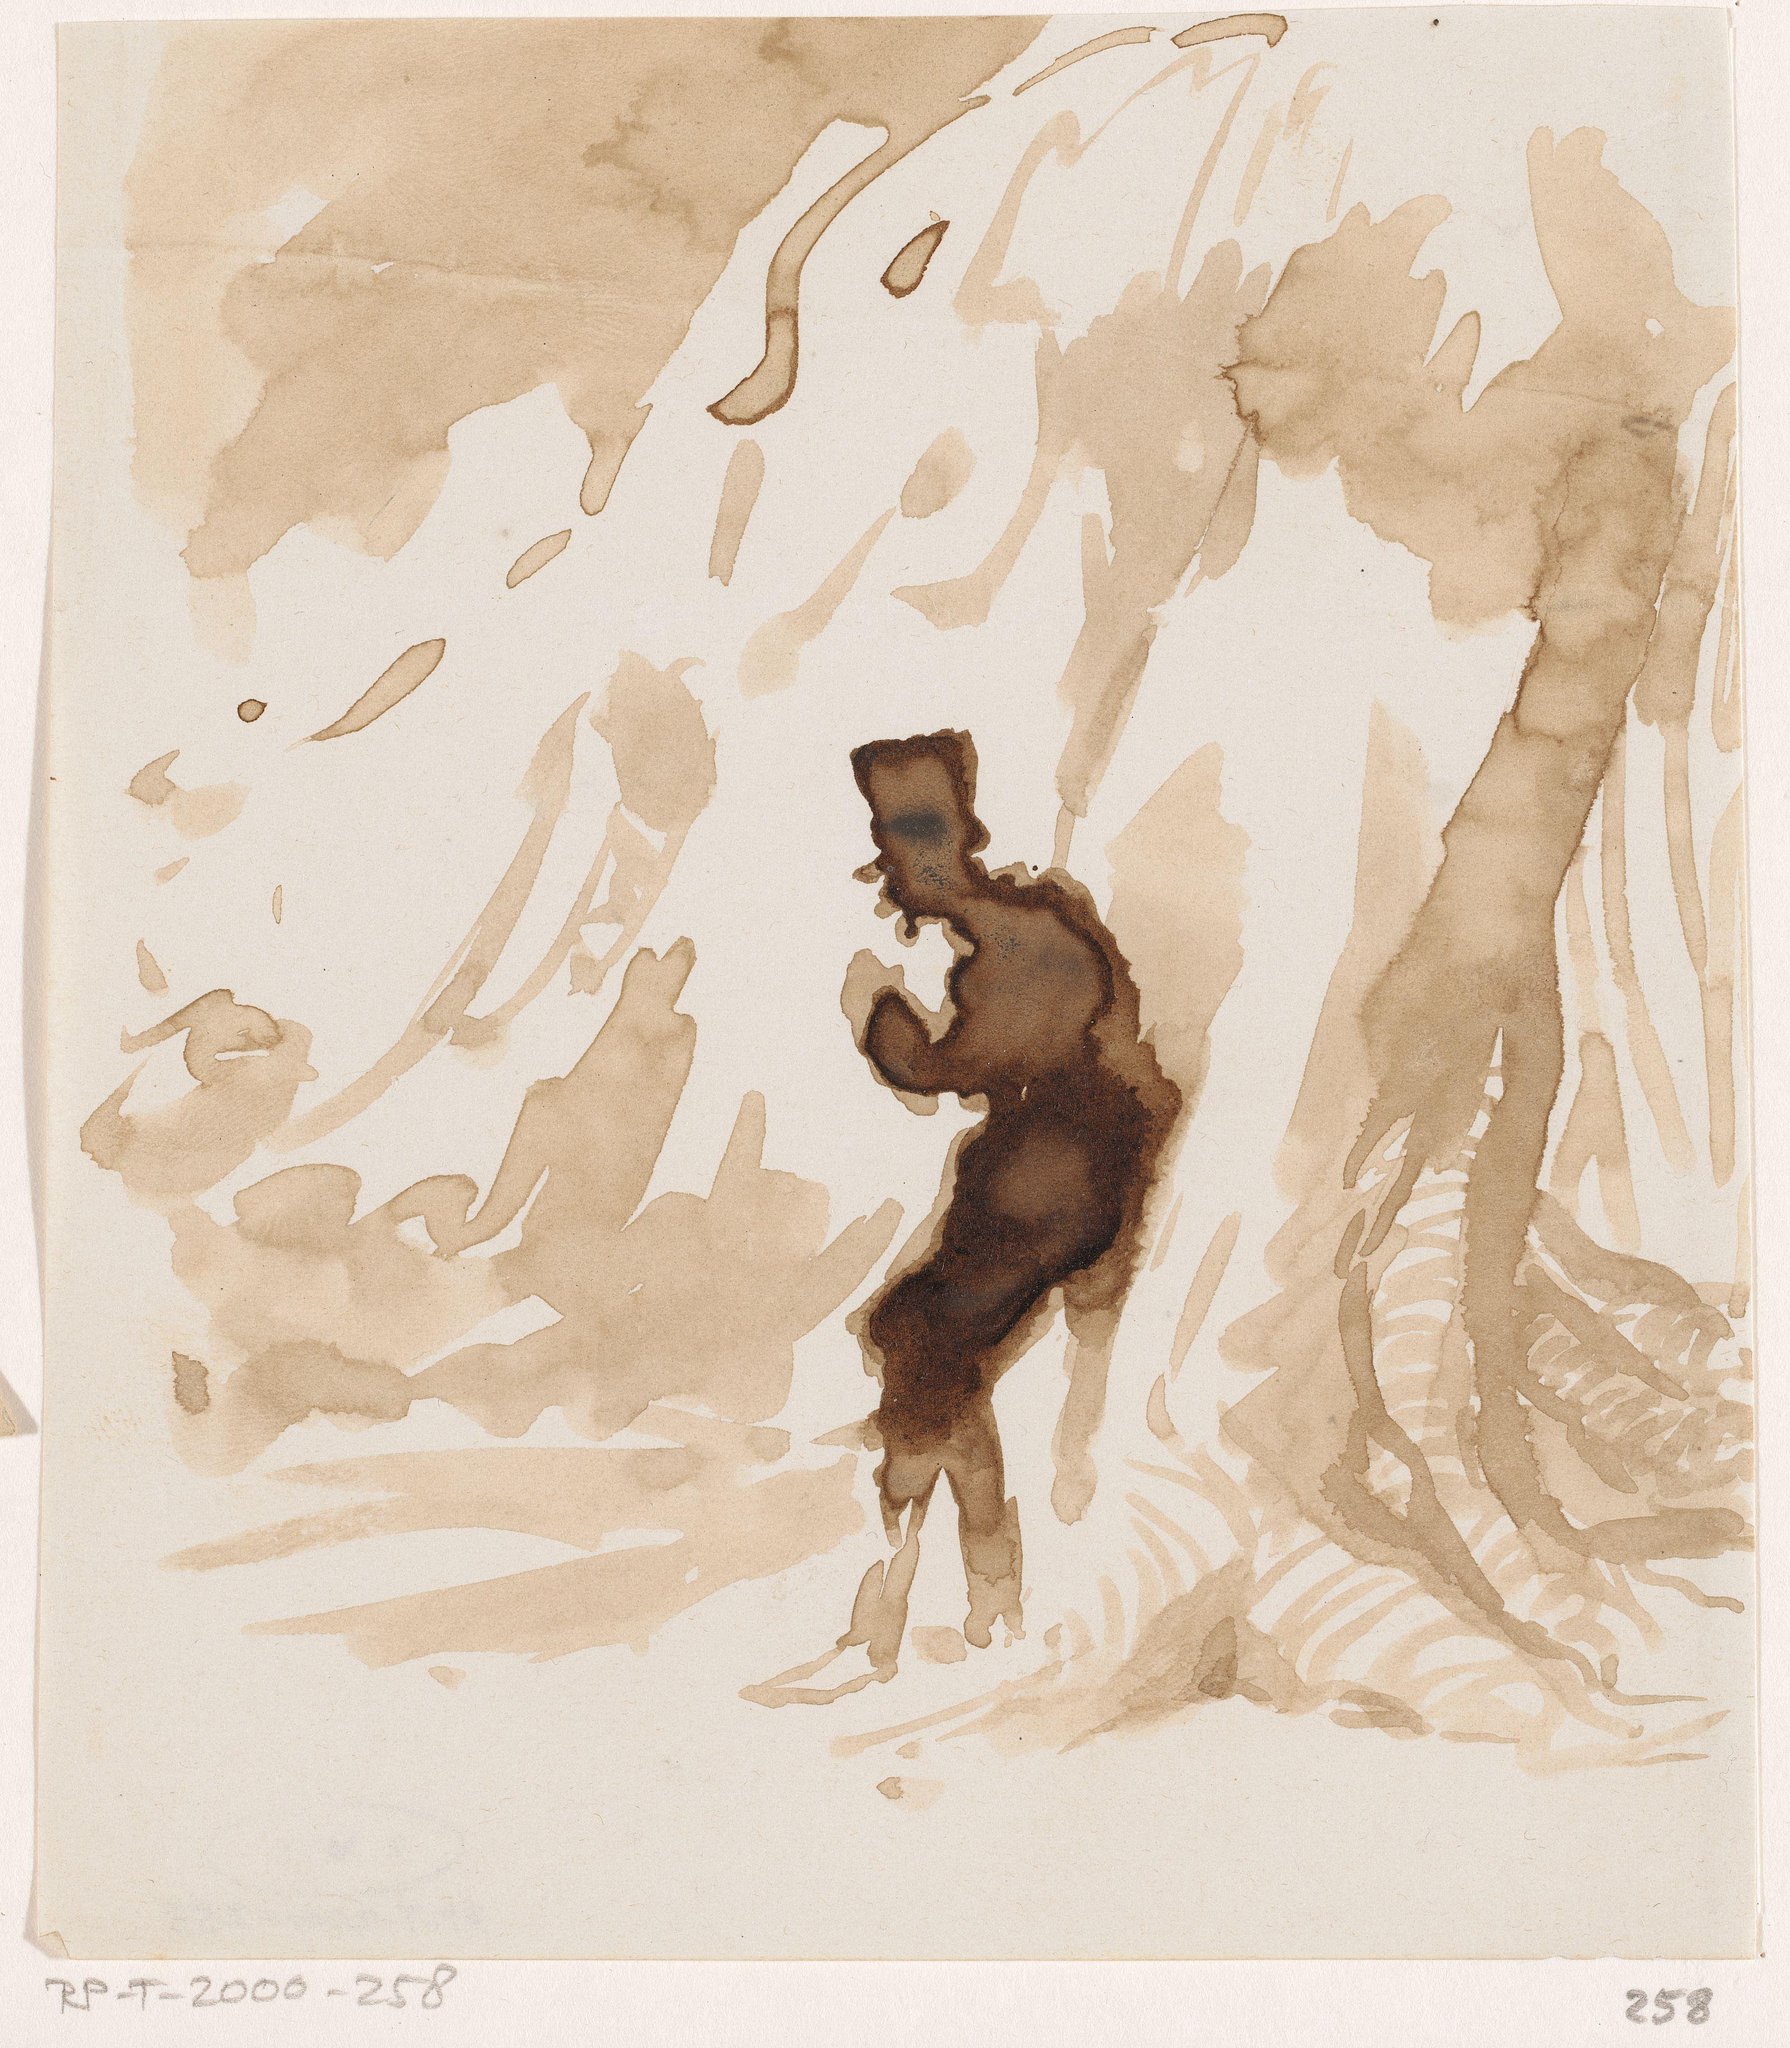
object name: drawing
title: Man leunend tegen boom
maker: johannes tavenraat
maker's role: draughtsman, painter, print maker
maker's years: 1809-1881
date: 1840-1880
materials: ink, paper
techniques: brush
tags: leaning figure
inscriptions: collector's mark: Lugt 2228